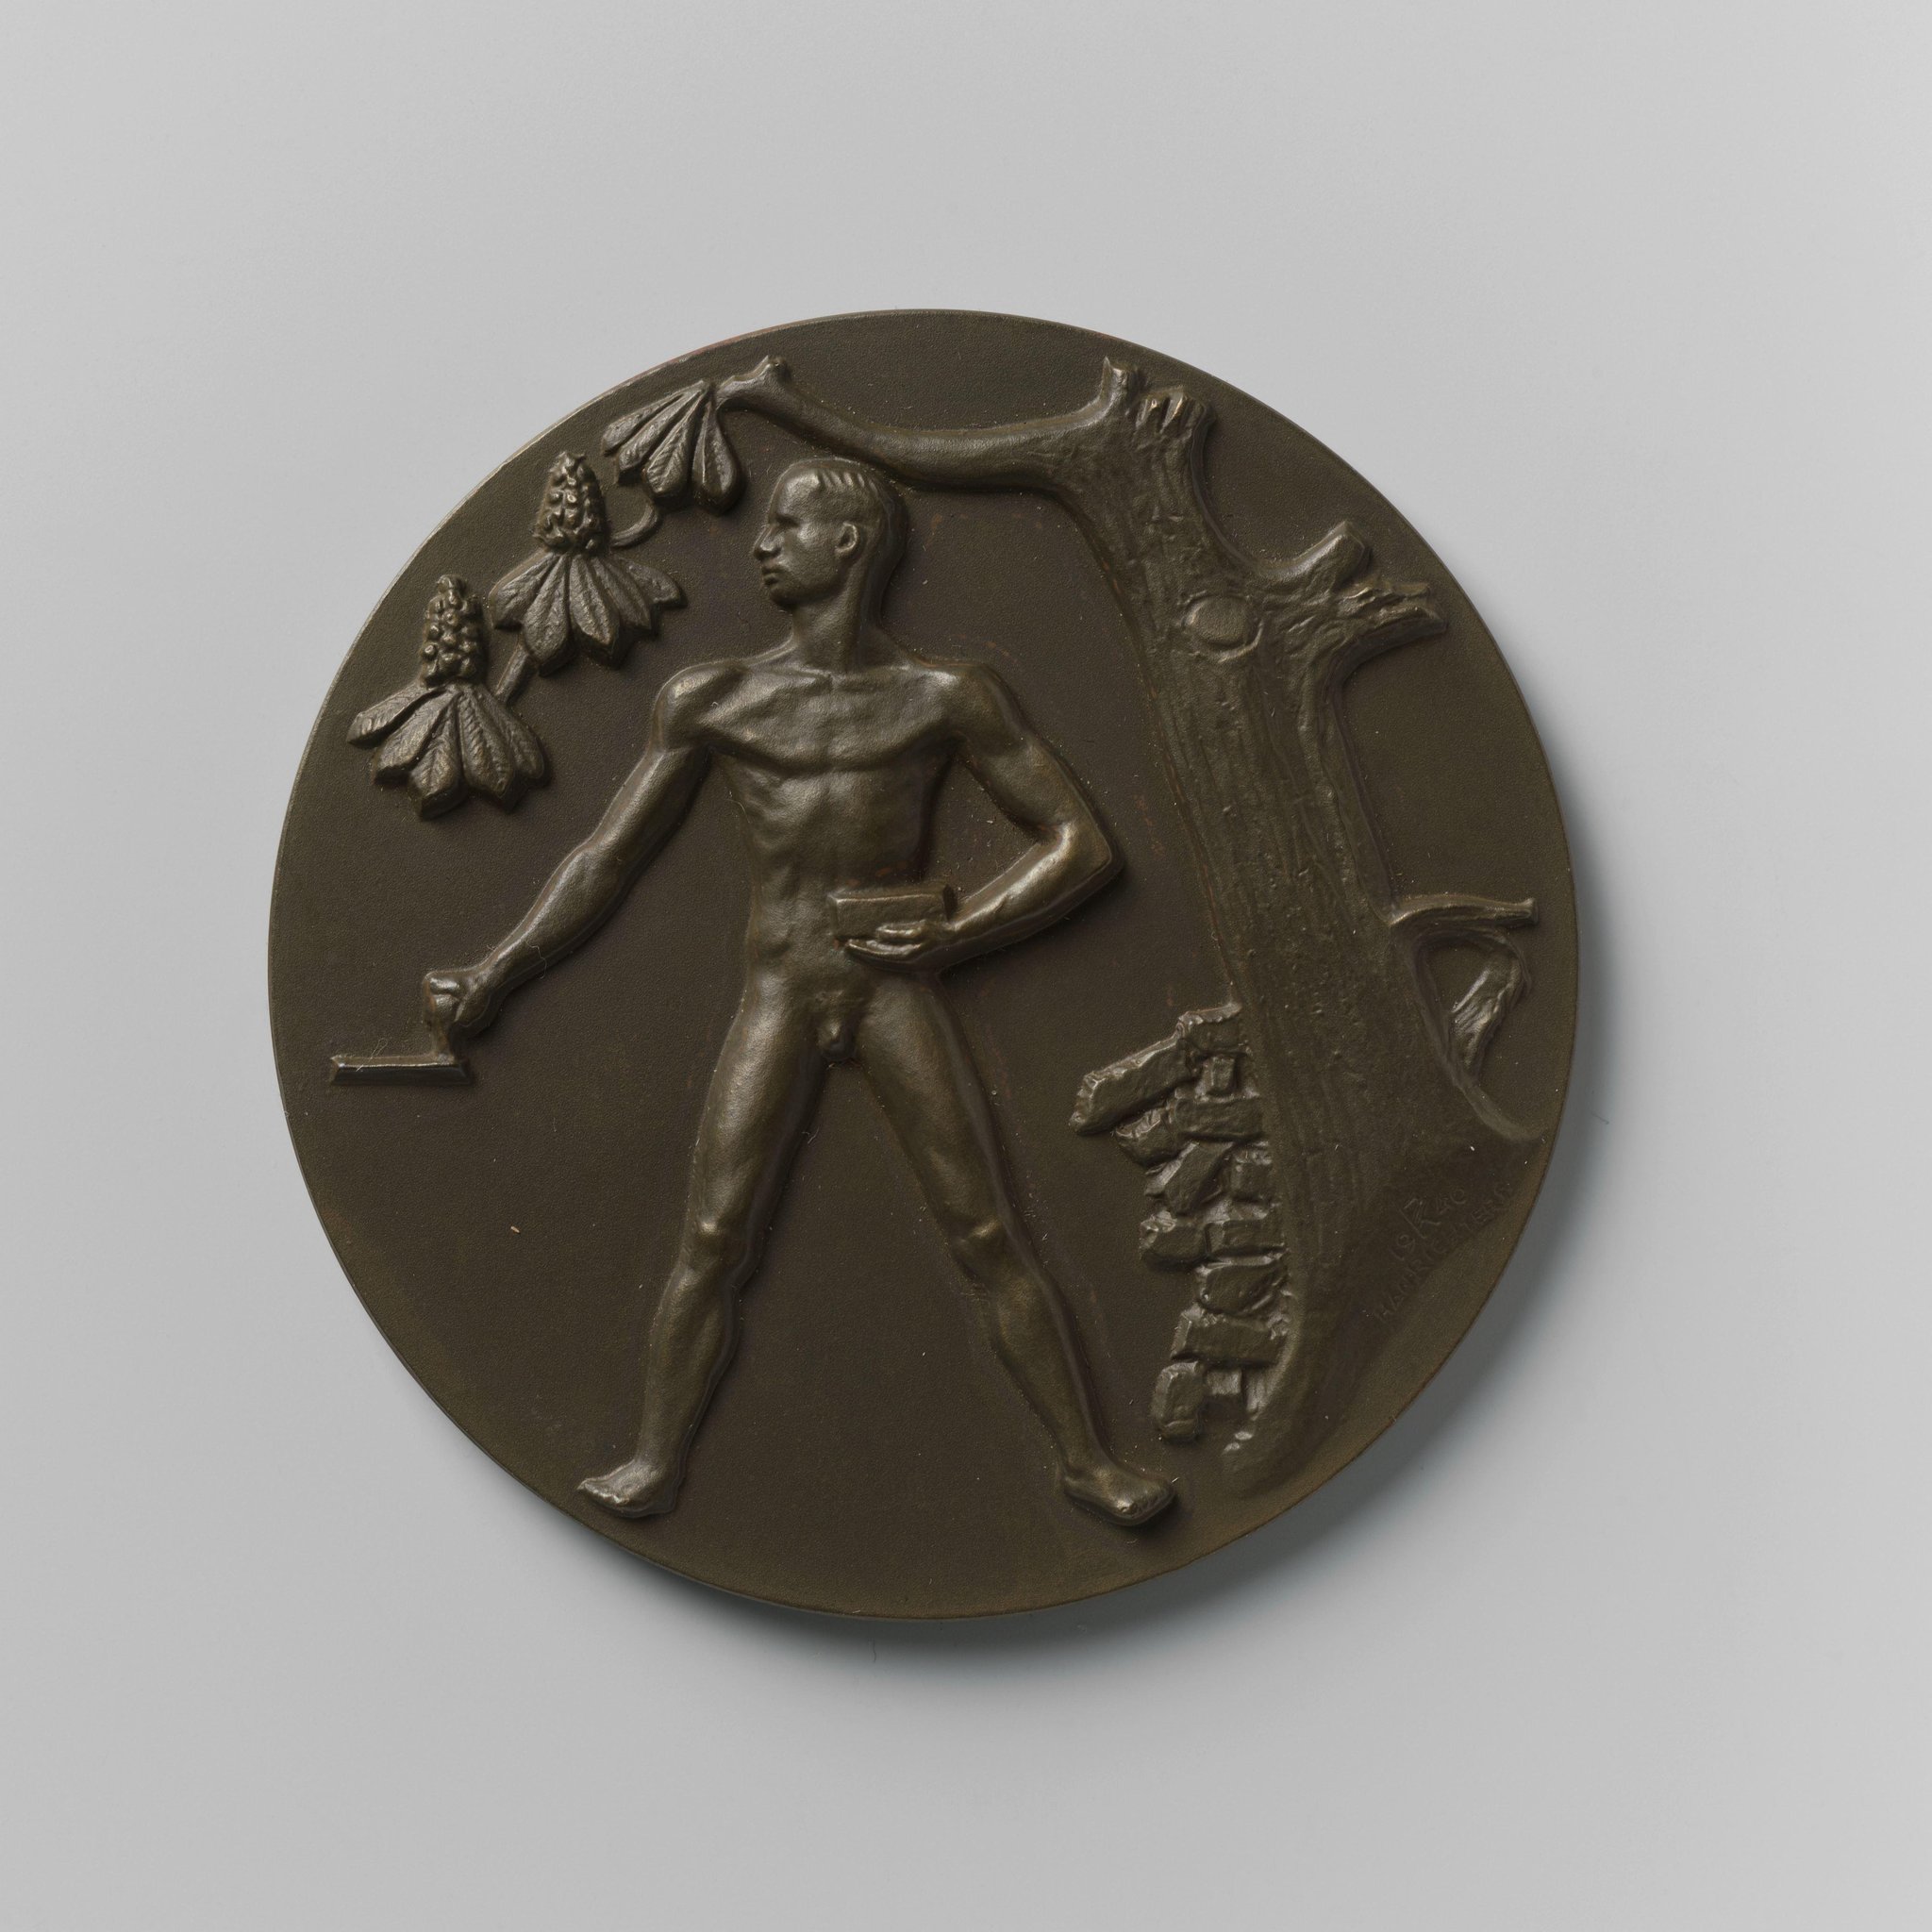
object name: history medal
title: Opbouw (Vereniging voor Penningkunst 1940, tweede penning)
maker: han richters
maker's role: draughtsman, sculptor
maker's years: 1915-2000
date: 1940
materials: bronze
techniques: striking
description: Bronzen penning, op de voorzijde een naakte man met troffel en stenen onder een bloeiende boom, op de keerzijde zes regels tekst met drie bloemornamenten.